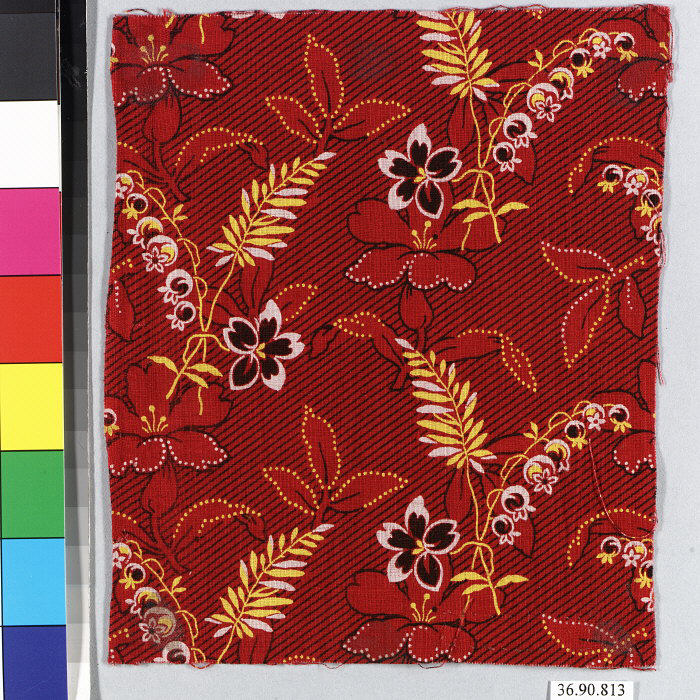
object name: piece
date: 1867-1900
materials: cotton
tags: flowers,leaves